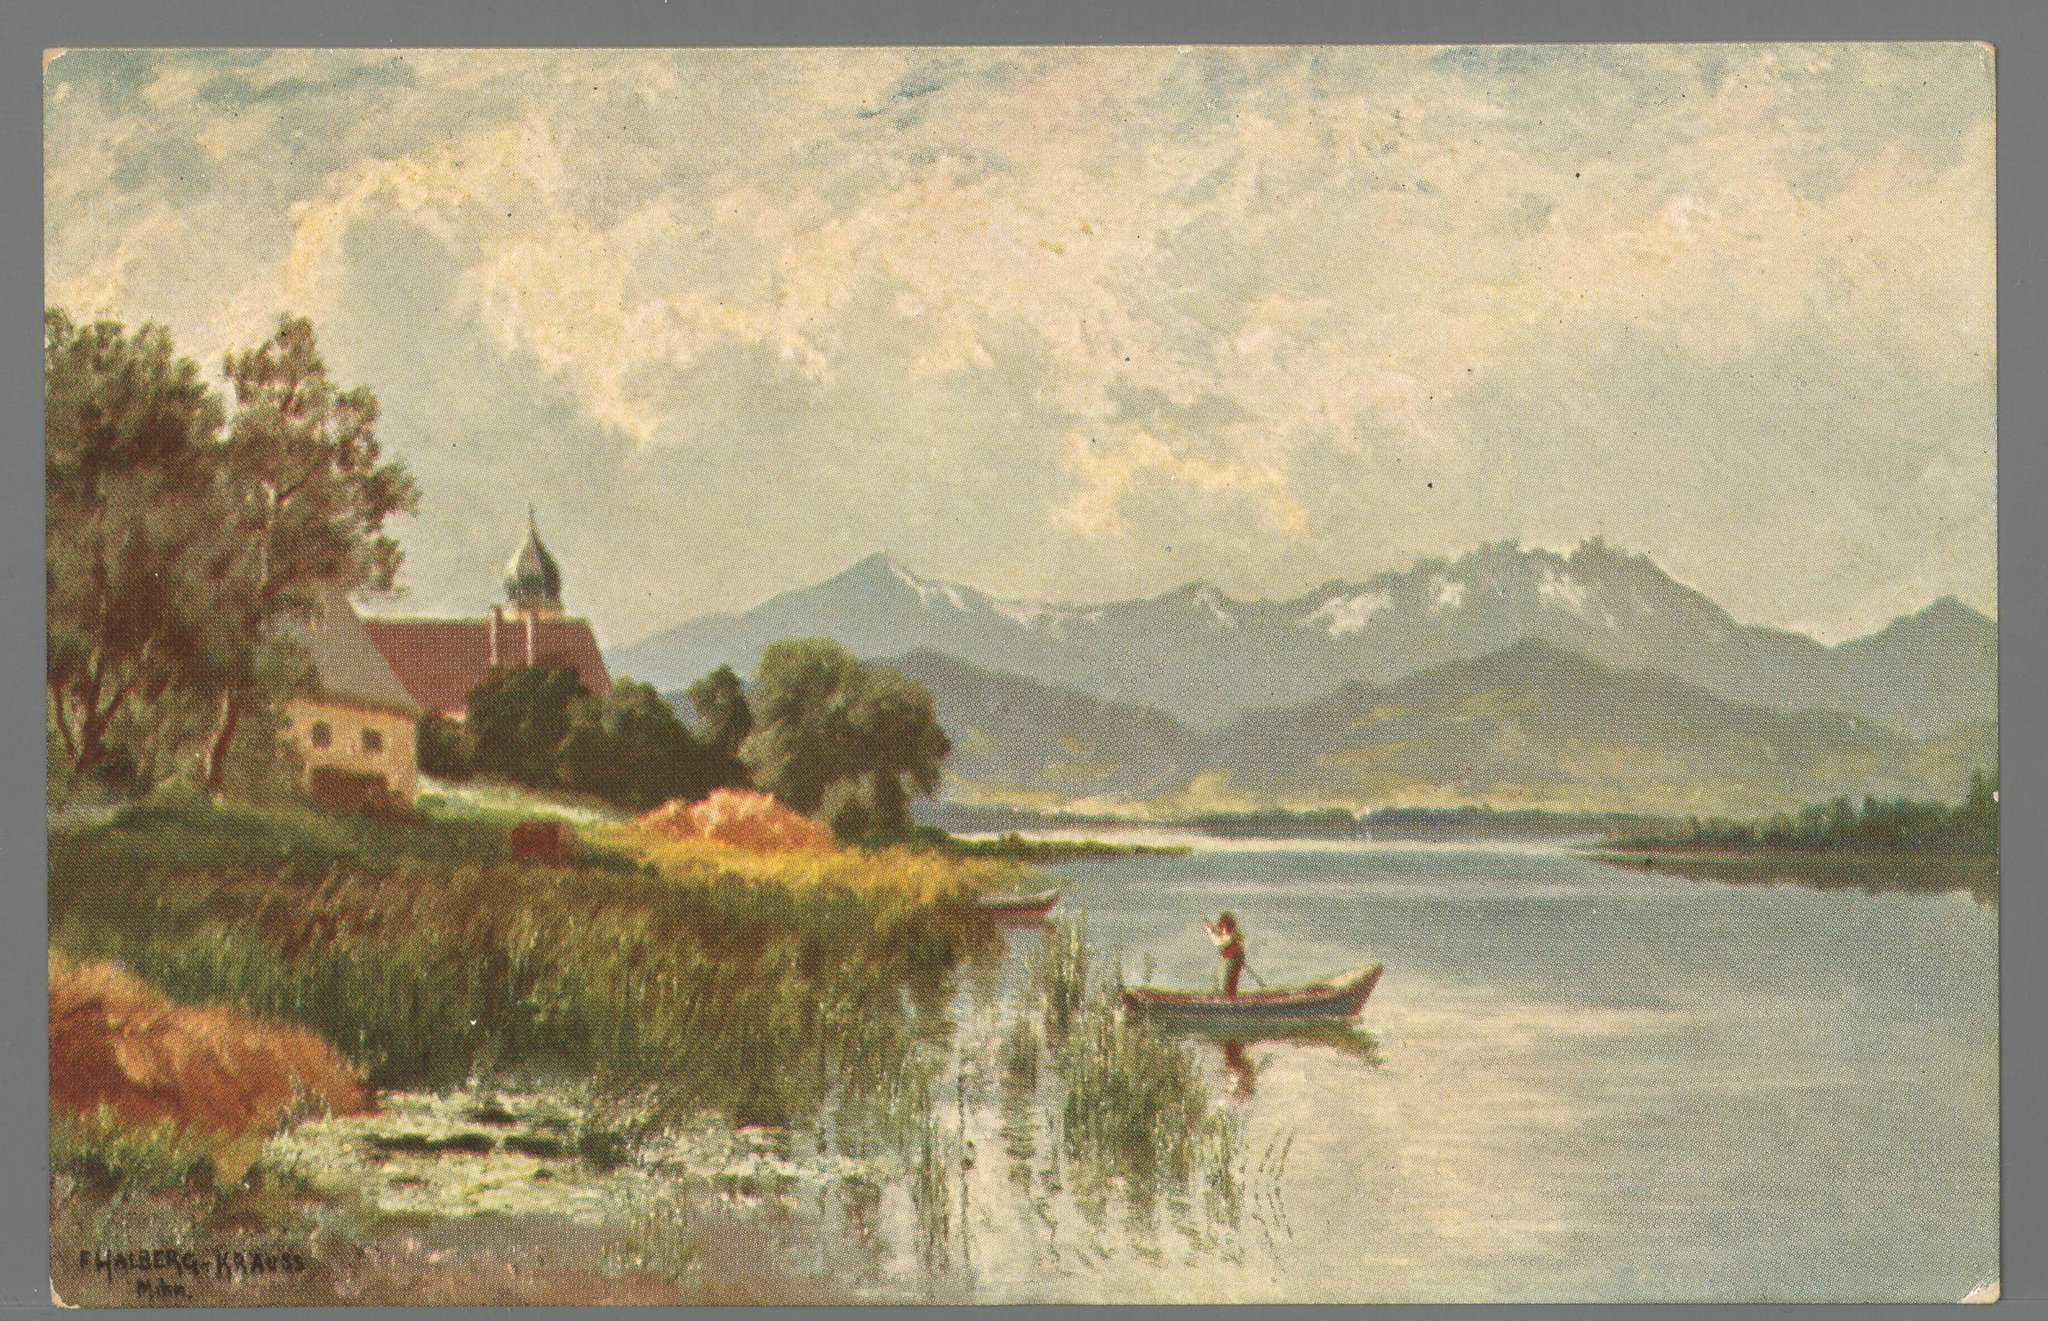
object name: reproduction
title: Langens Künstler-Karten Serie XV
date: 1905-1909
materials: cardboard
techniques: four-color autotype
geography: munich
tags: island (+ landscape with figures, staffage), mountain-range, snow peaks